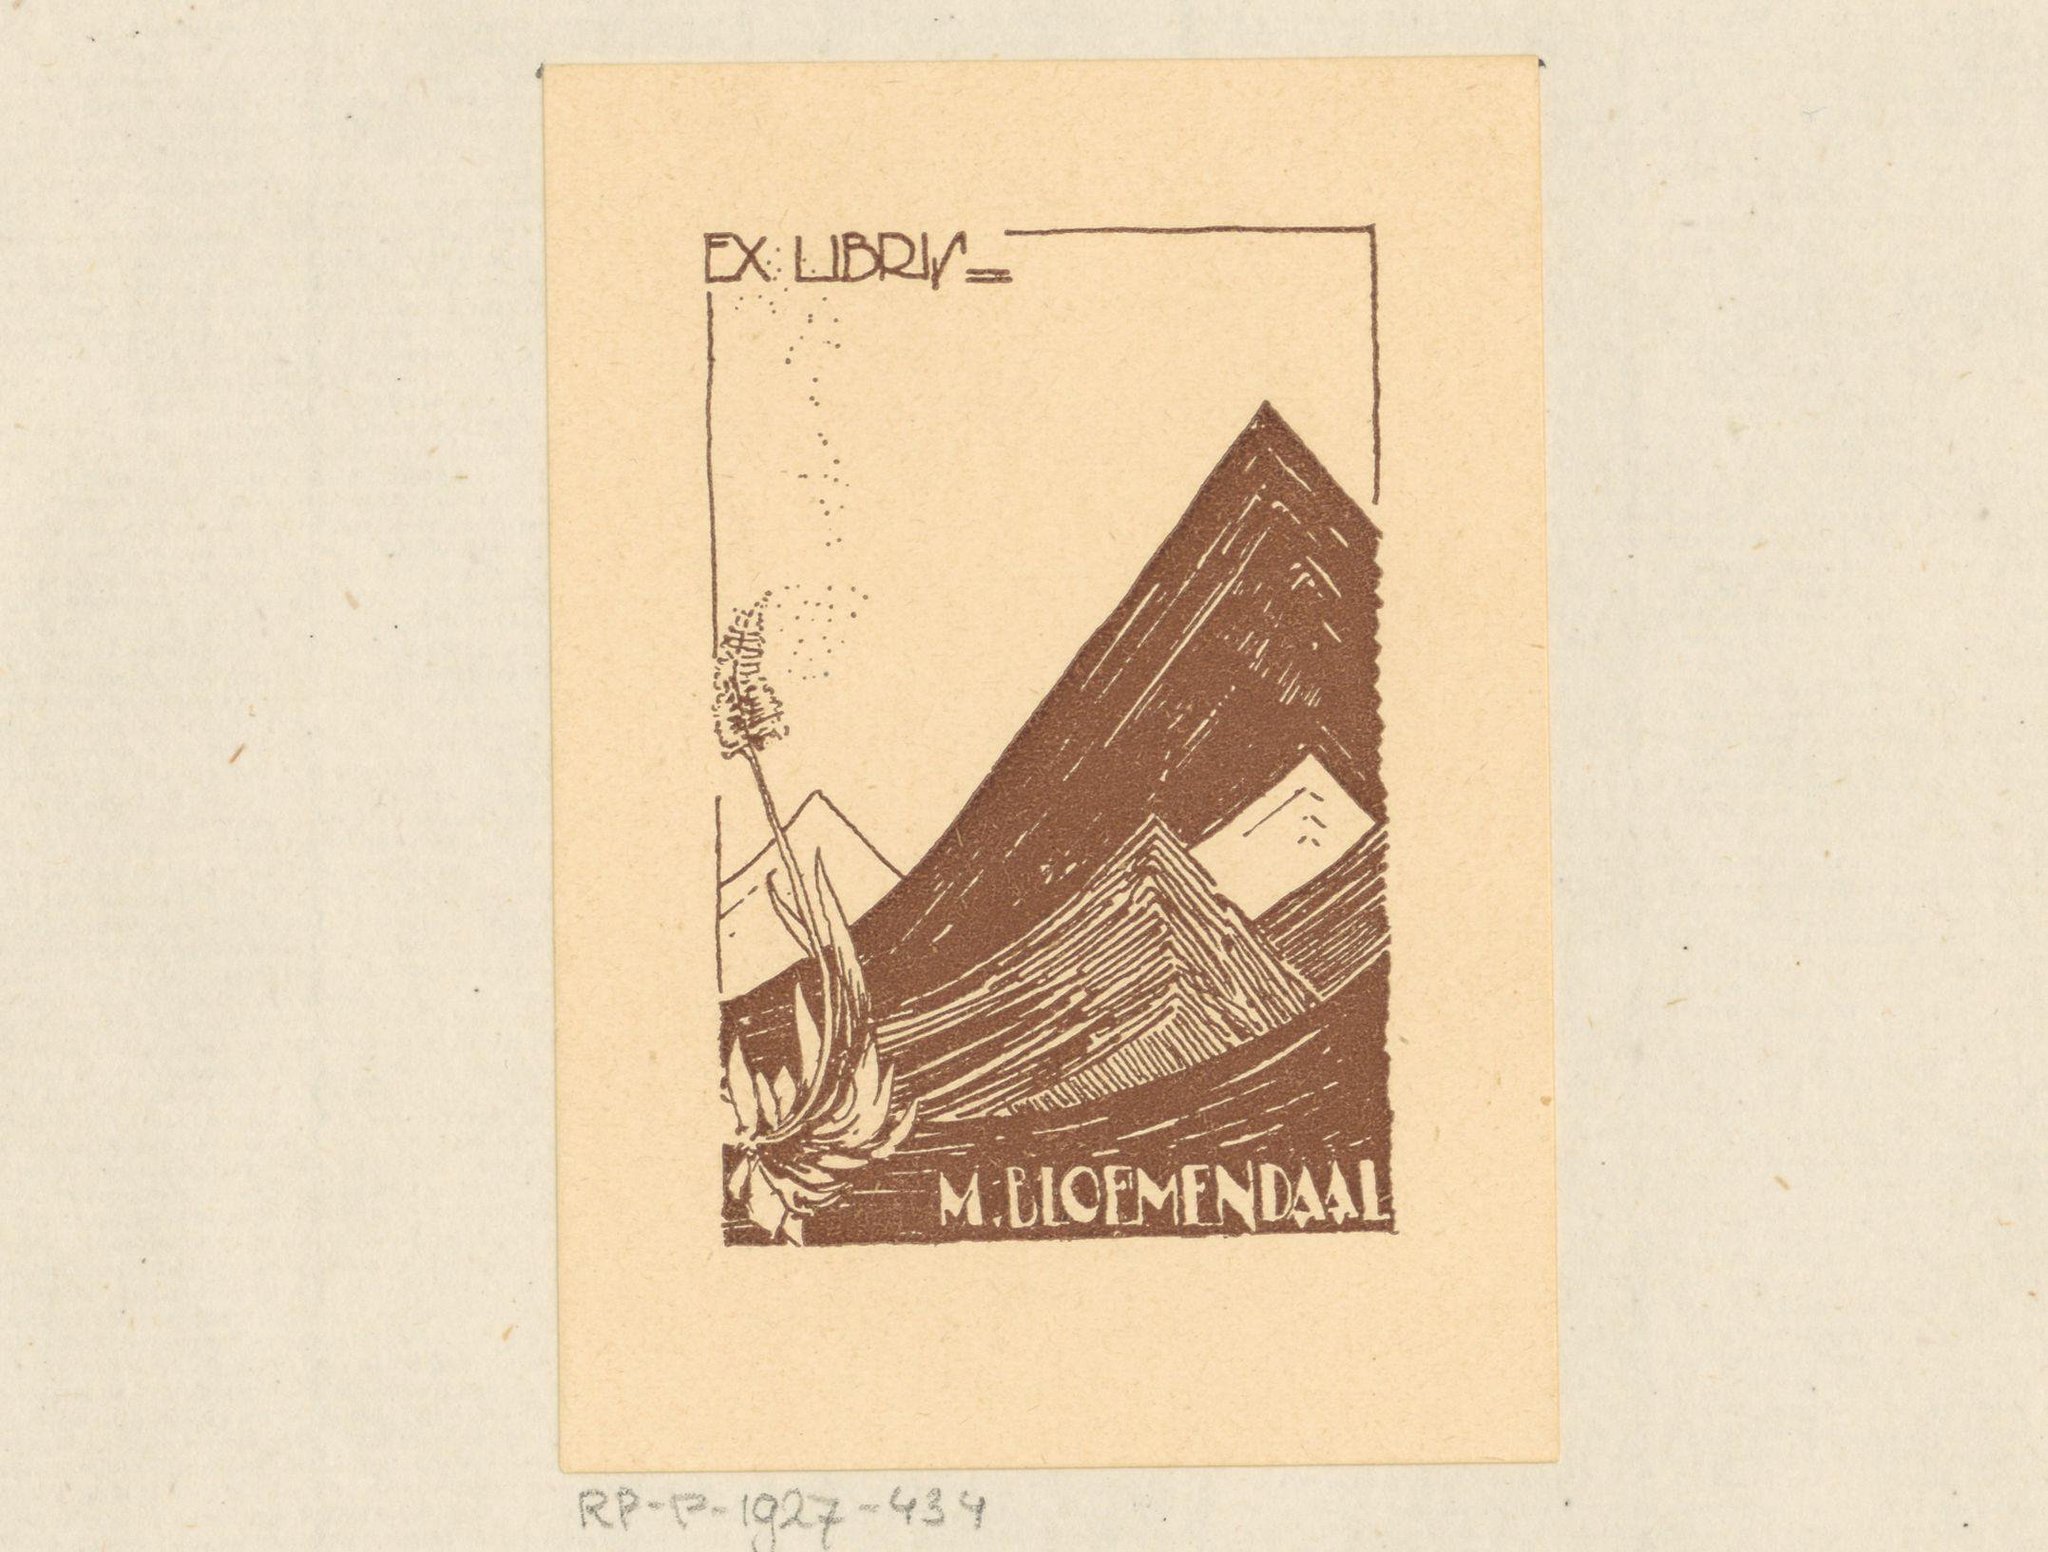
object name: bookplate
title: Ex libris van M. Bloemendaal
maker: Anonymous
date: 1900-1927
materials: paper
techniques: printing block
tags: mountains